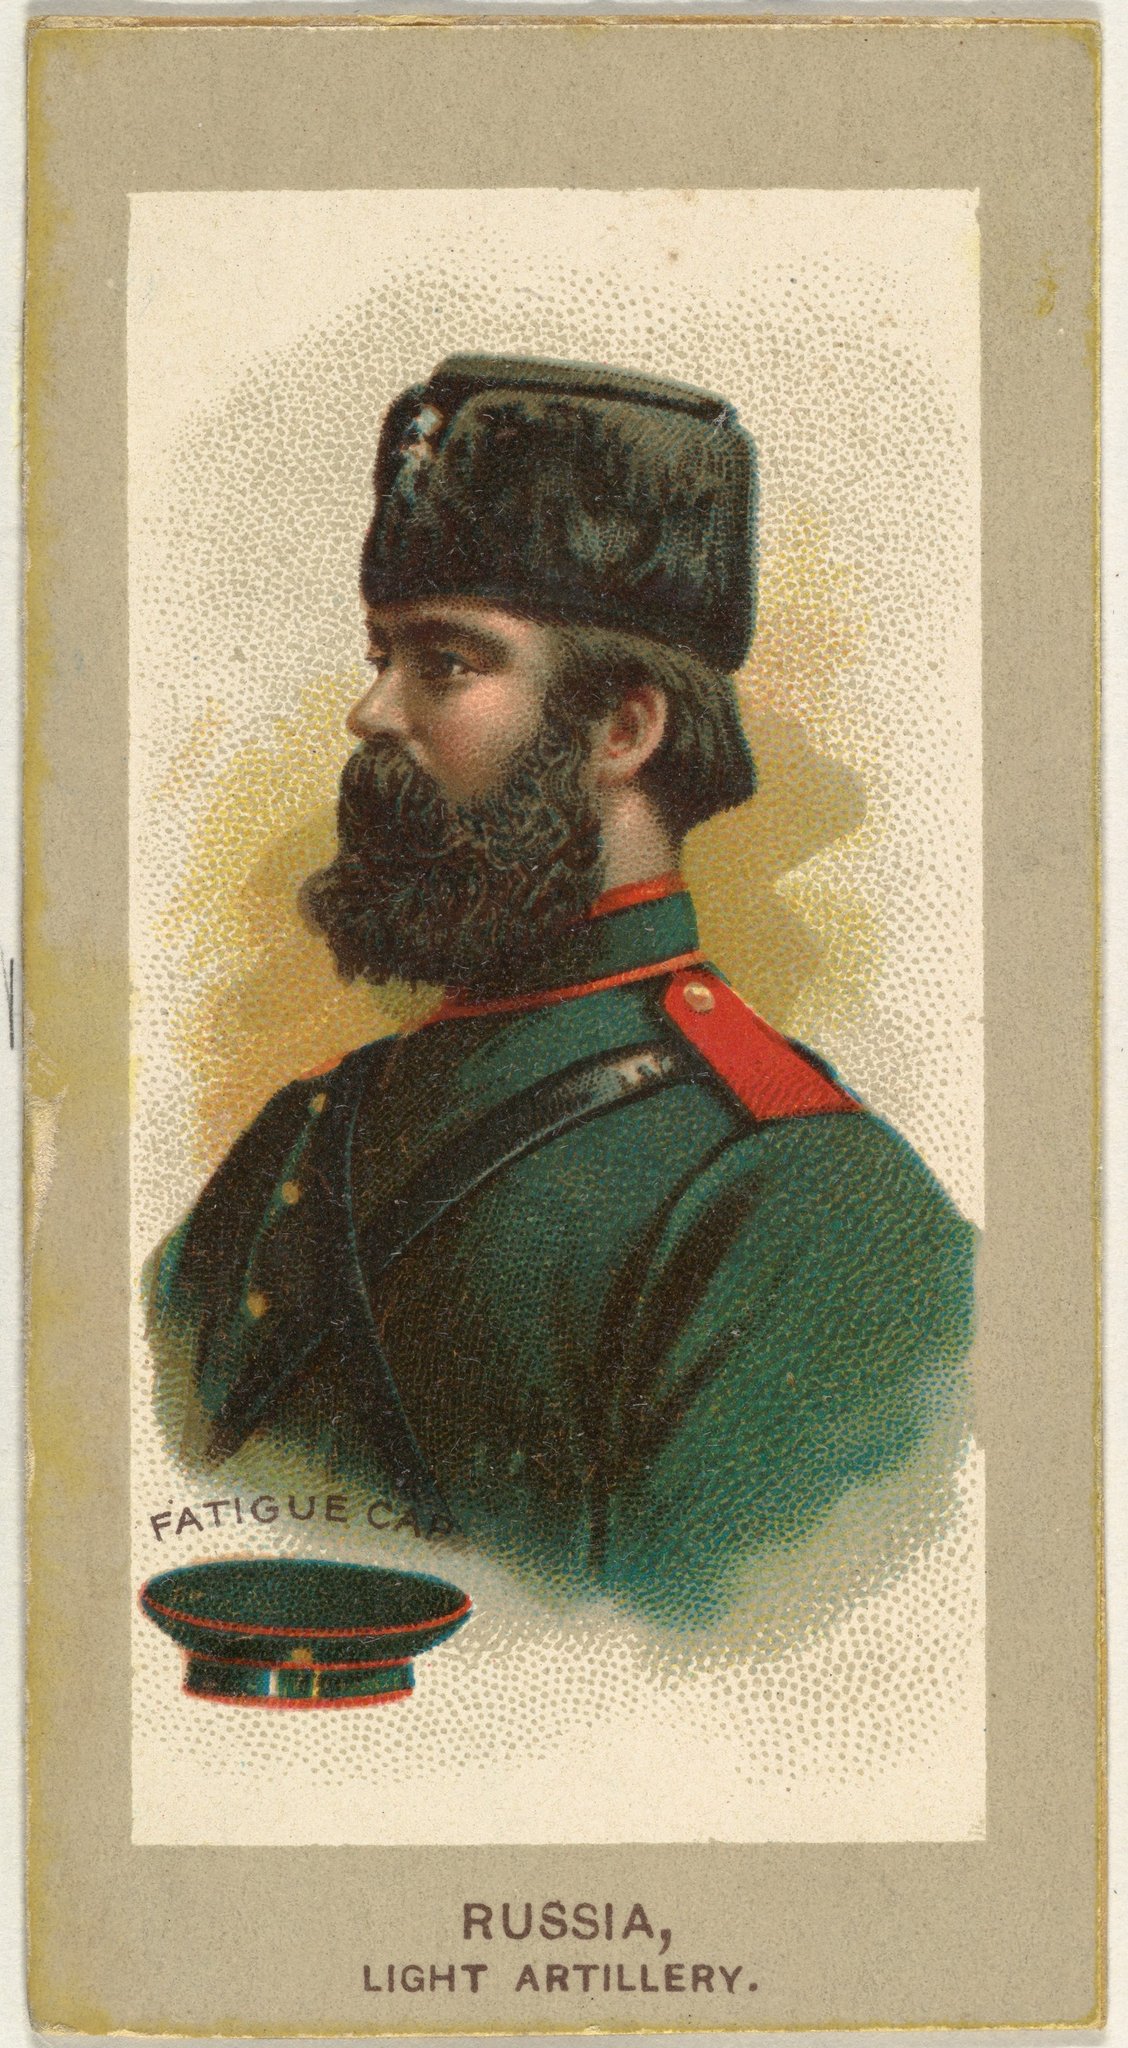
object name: print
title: Fatigue Cap, Light Artillery, Russia, from the Military Uniforms series (T182) issued by Abdul Cigarettes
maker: abdul cigarettes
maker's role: publisher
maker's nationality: american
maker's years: 1881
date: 1881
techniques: color lithograph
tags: men